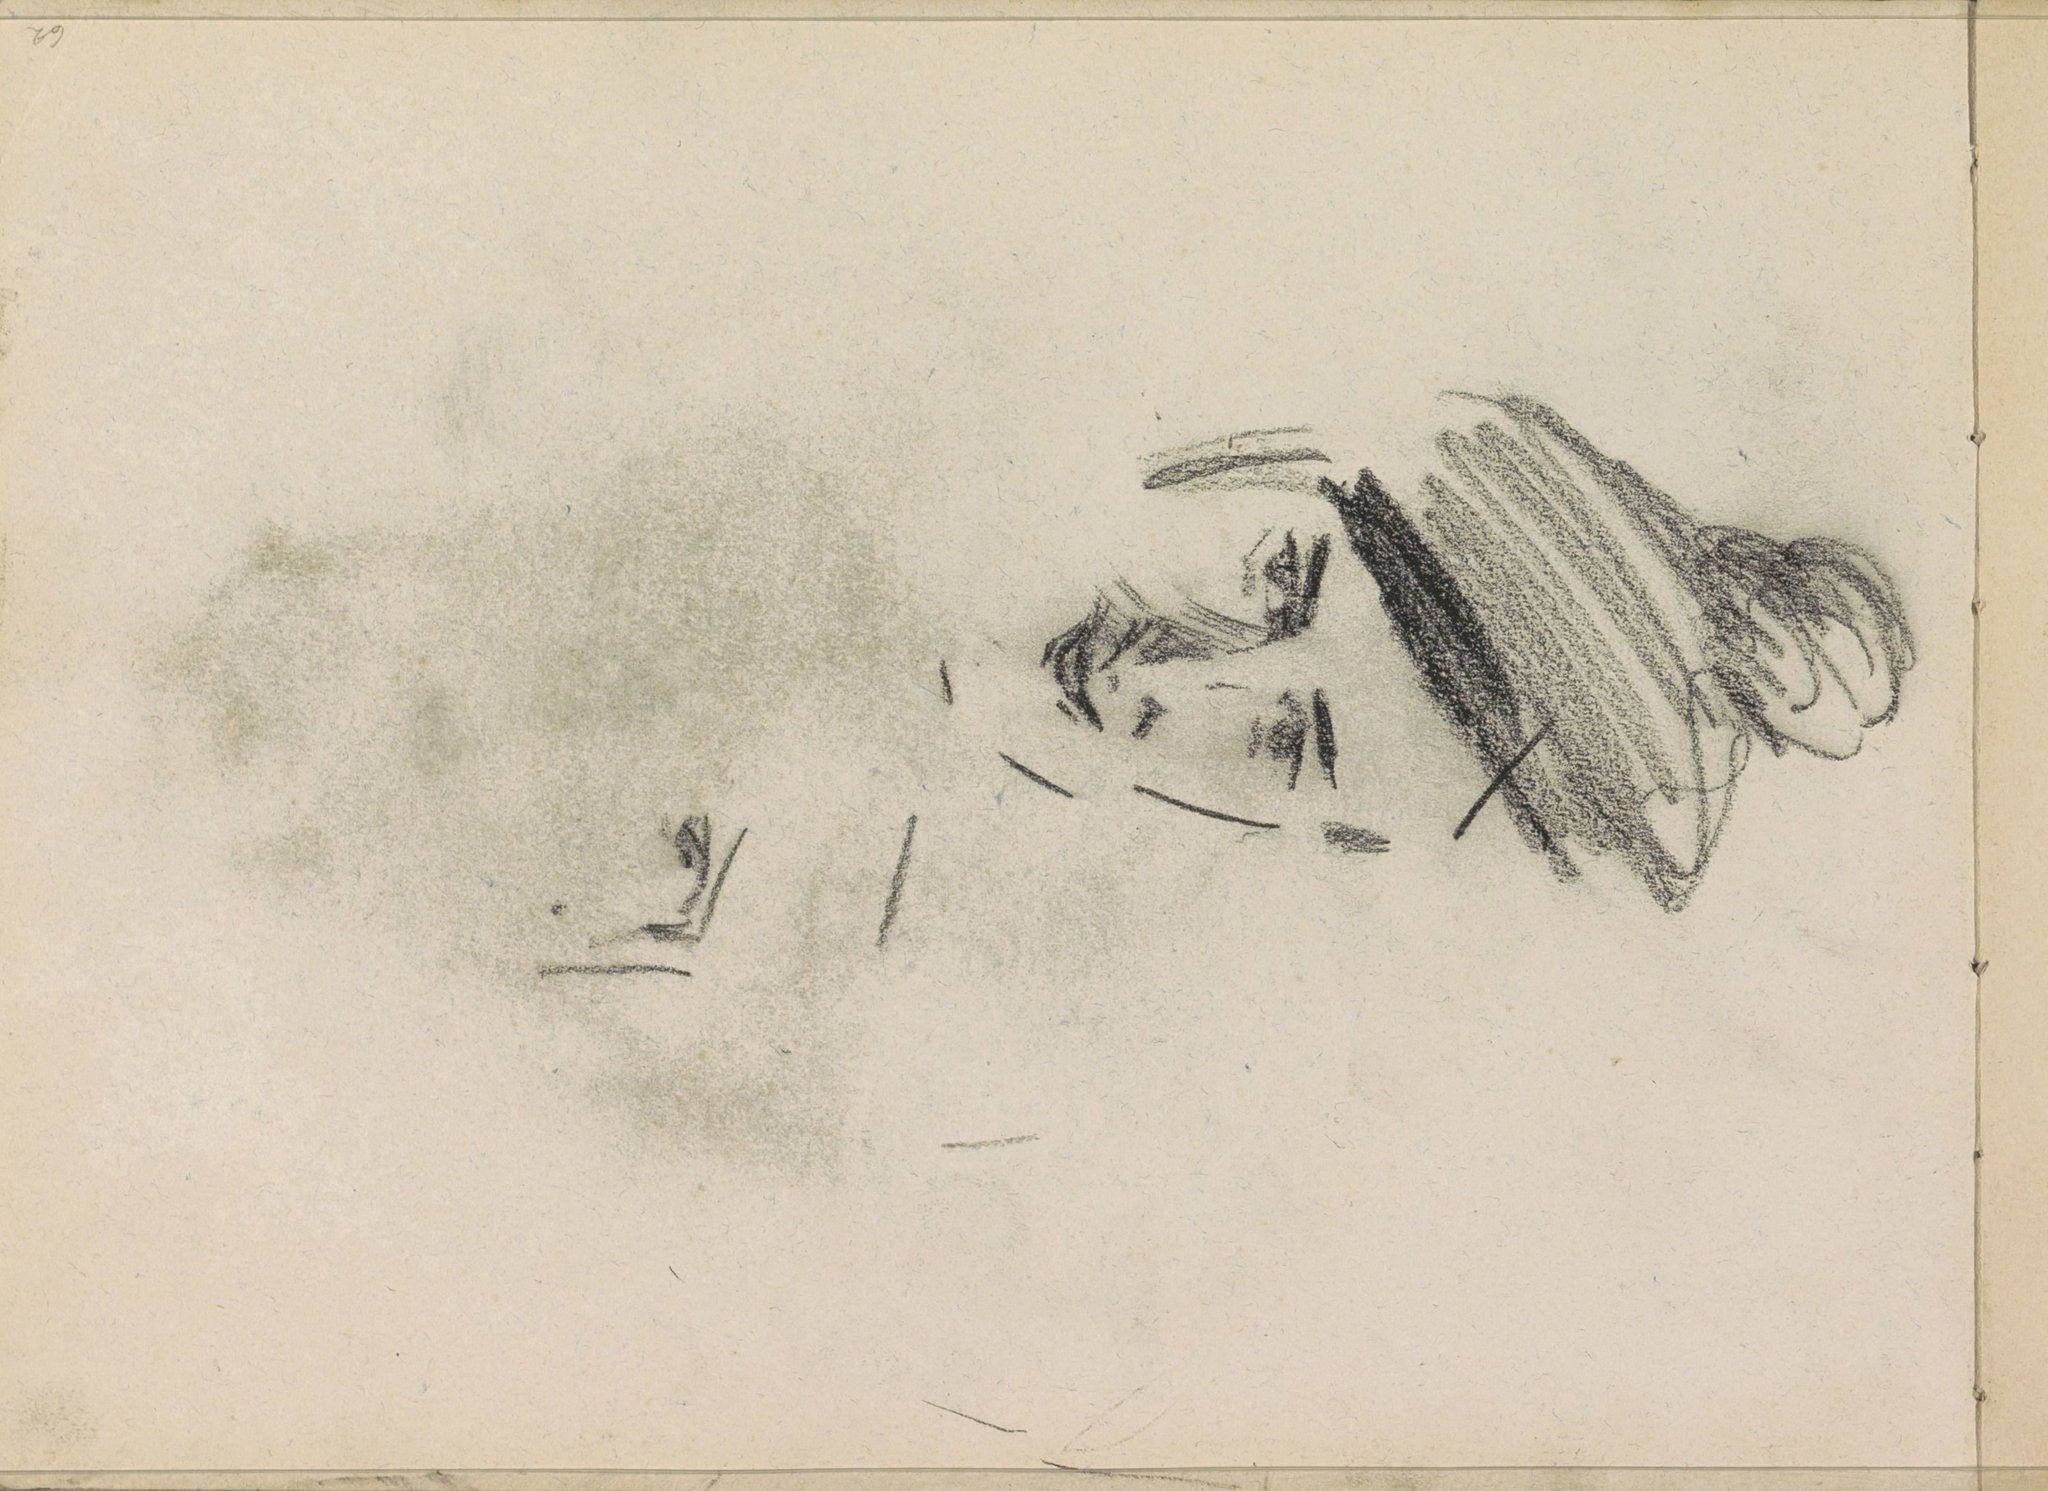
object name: sketchbook leaf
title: Vrouwenhoofd met hoed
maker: isaac israels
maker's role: draughtsman, painter, print maker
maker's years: 1865-1934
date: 1890-1920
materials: chalk, paper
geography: the hague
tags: head-gear: hat (+ women's clothes), head (human) - aa - female human figure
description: Blad 25 verso uit schetsboek X met 43 bladen.